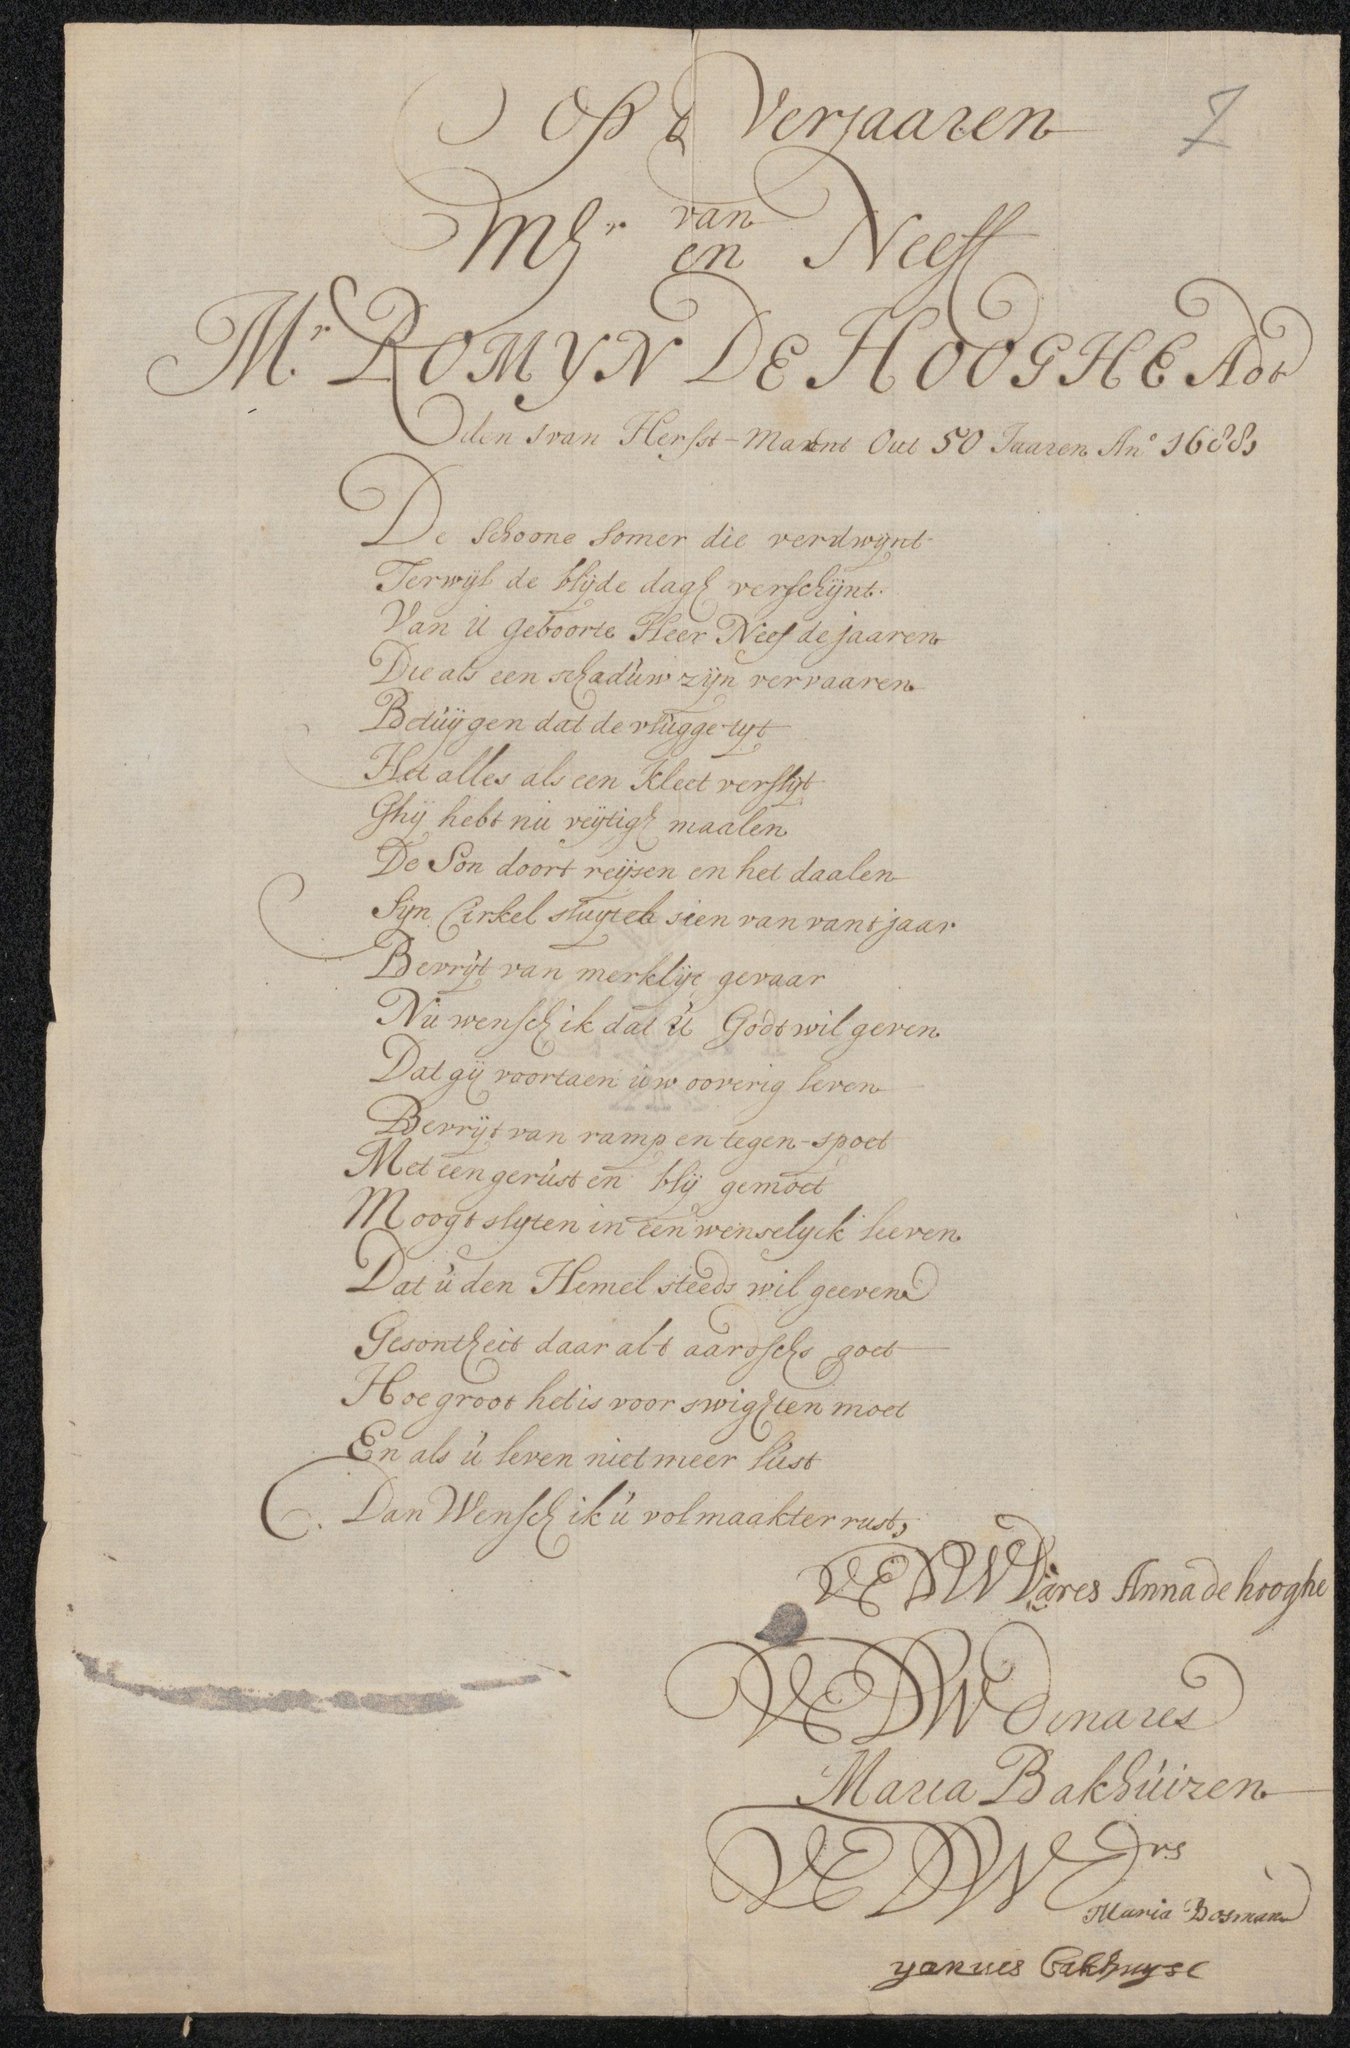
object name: poem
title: Gedicht op de vijftigste verjaardag van Romeyn de Hooghe (1638-1710)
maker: anna de hooghe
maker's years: 1645-1717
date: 1688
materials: ink, paper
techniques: pen, writing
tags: advocaat, romeyn de hooghe (1638-1710)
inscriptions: collector's mark: Lugt 2233, watermark